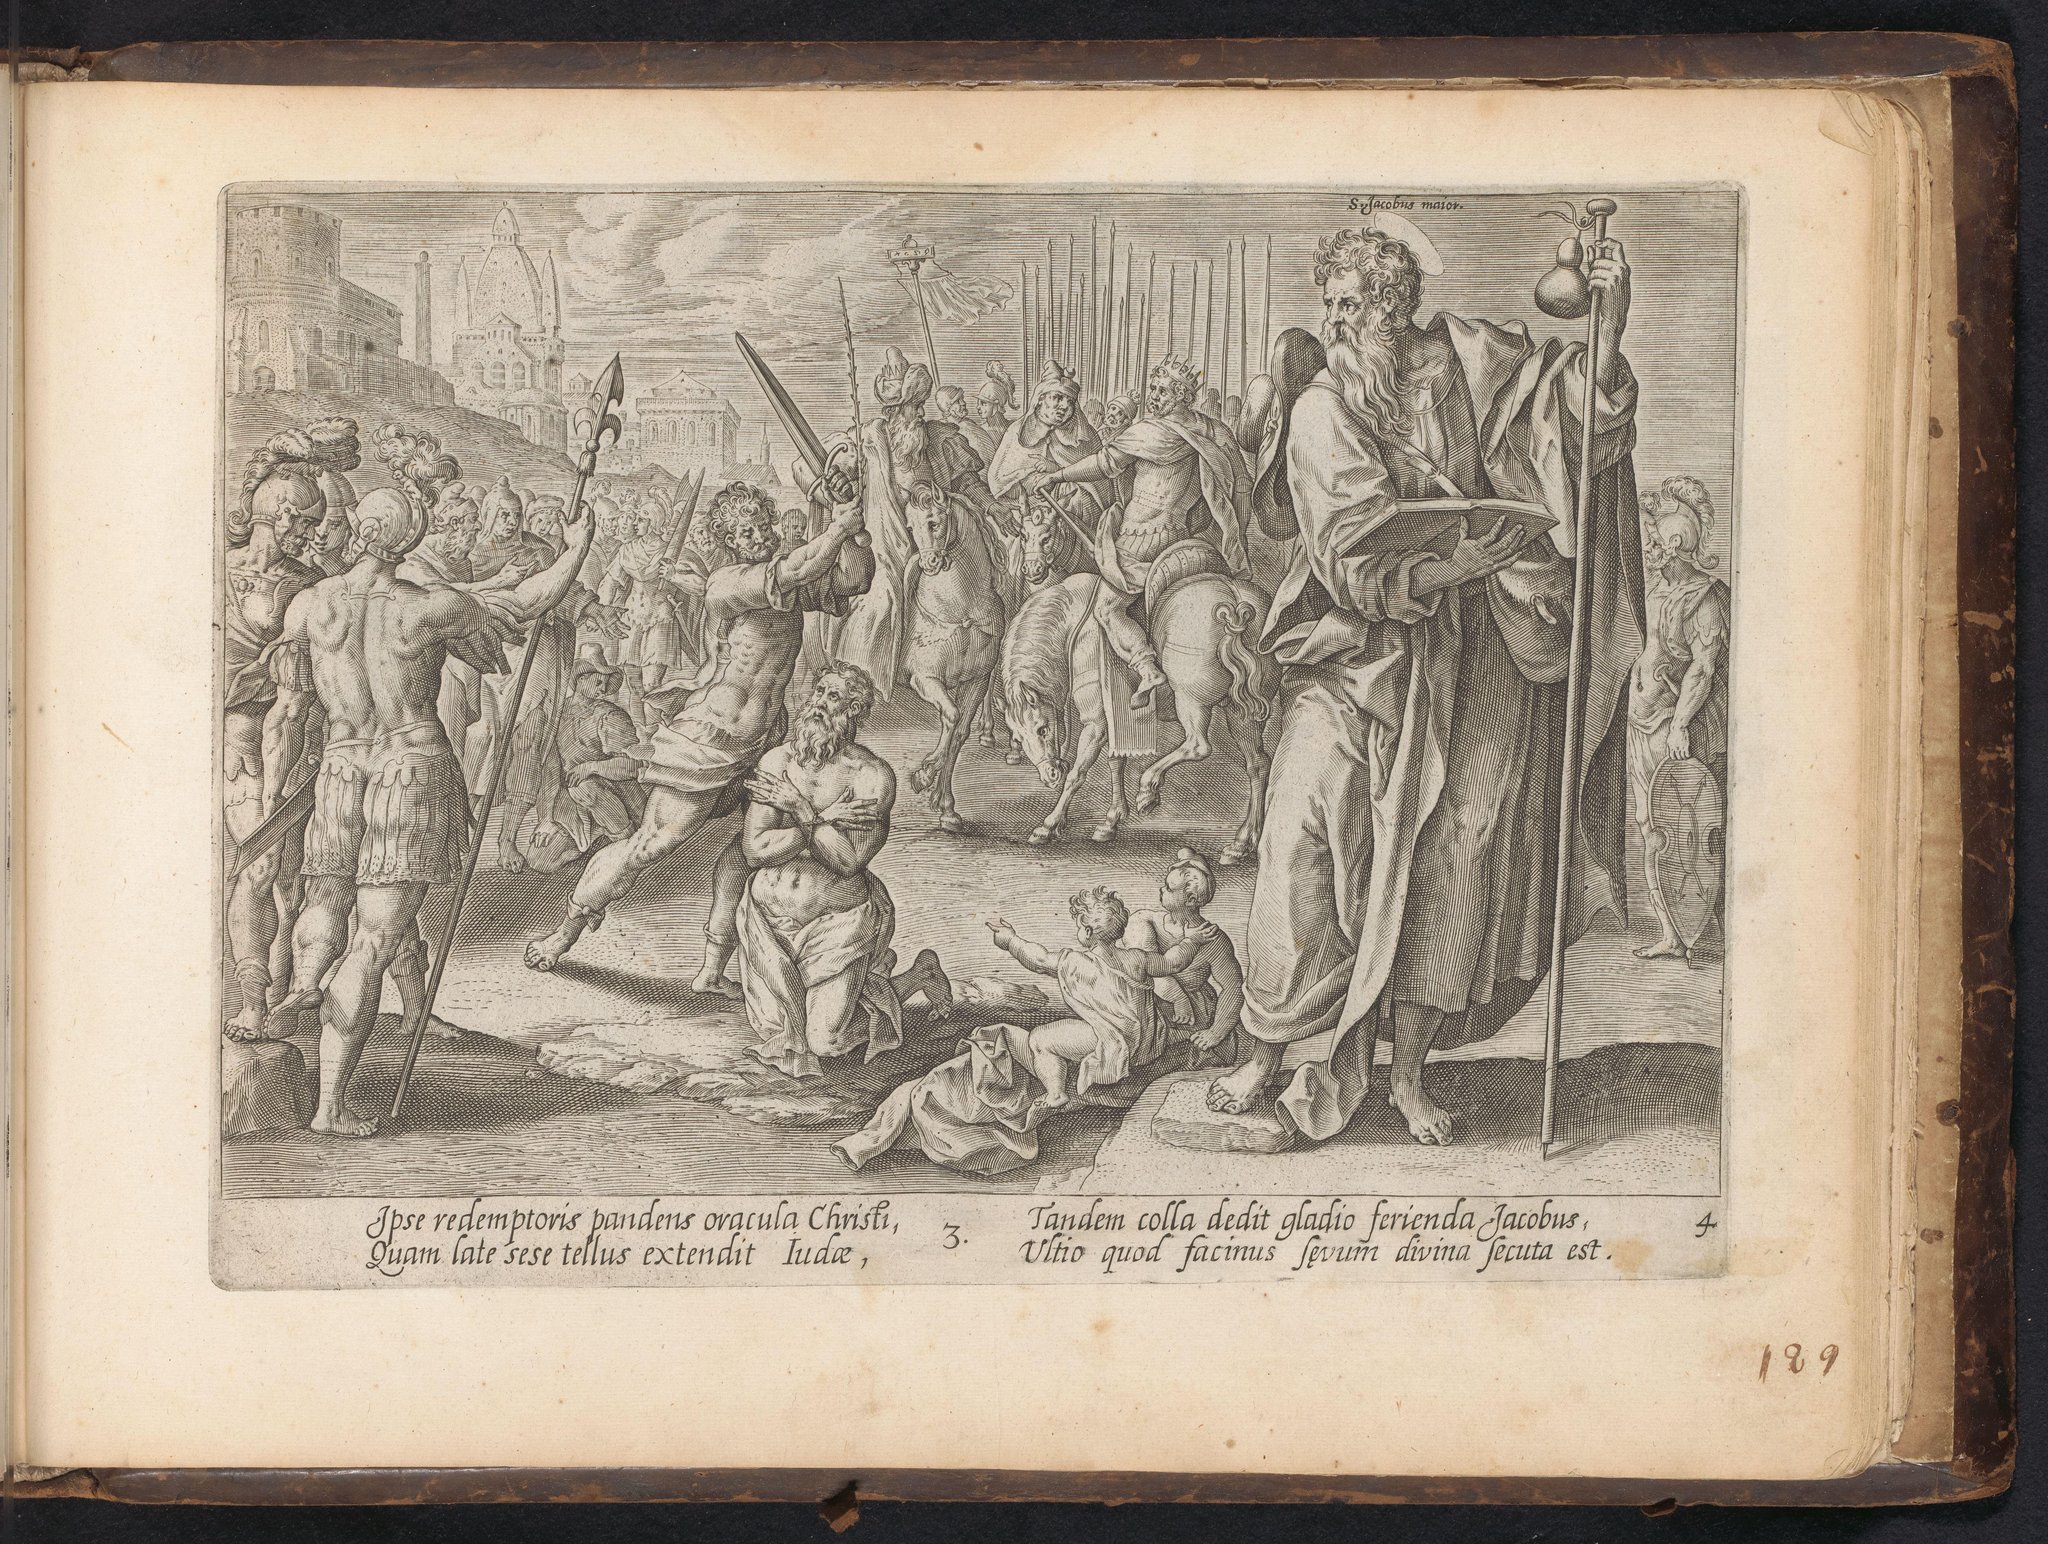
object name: album leaf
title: Martelaarschap van Jakobus de Meerdere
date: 1576-1580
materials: paper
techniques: engraving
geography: alkmaar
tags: beheading of james, the apostle james the great; possible attributes: book, pilgrim's cloak, hat, shell, staff, and wallet, scroll, sword - martyrdom, suffering, misfortune, death of male saint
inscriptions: number: ‘189’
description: Jakobus de Meerdere wordt onthoofd met een zwaard; rechts naast het tafereel van zijn marteldood staat hij nogmaals afgebeeld, met een pelgrimsstaf in de hand waaraan een kalebasfles bungelt. Onder de voorstelling een verklarende tekst in het Latijn. Deze prent maakt deel uit van een album.